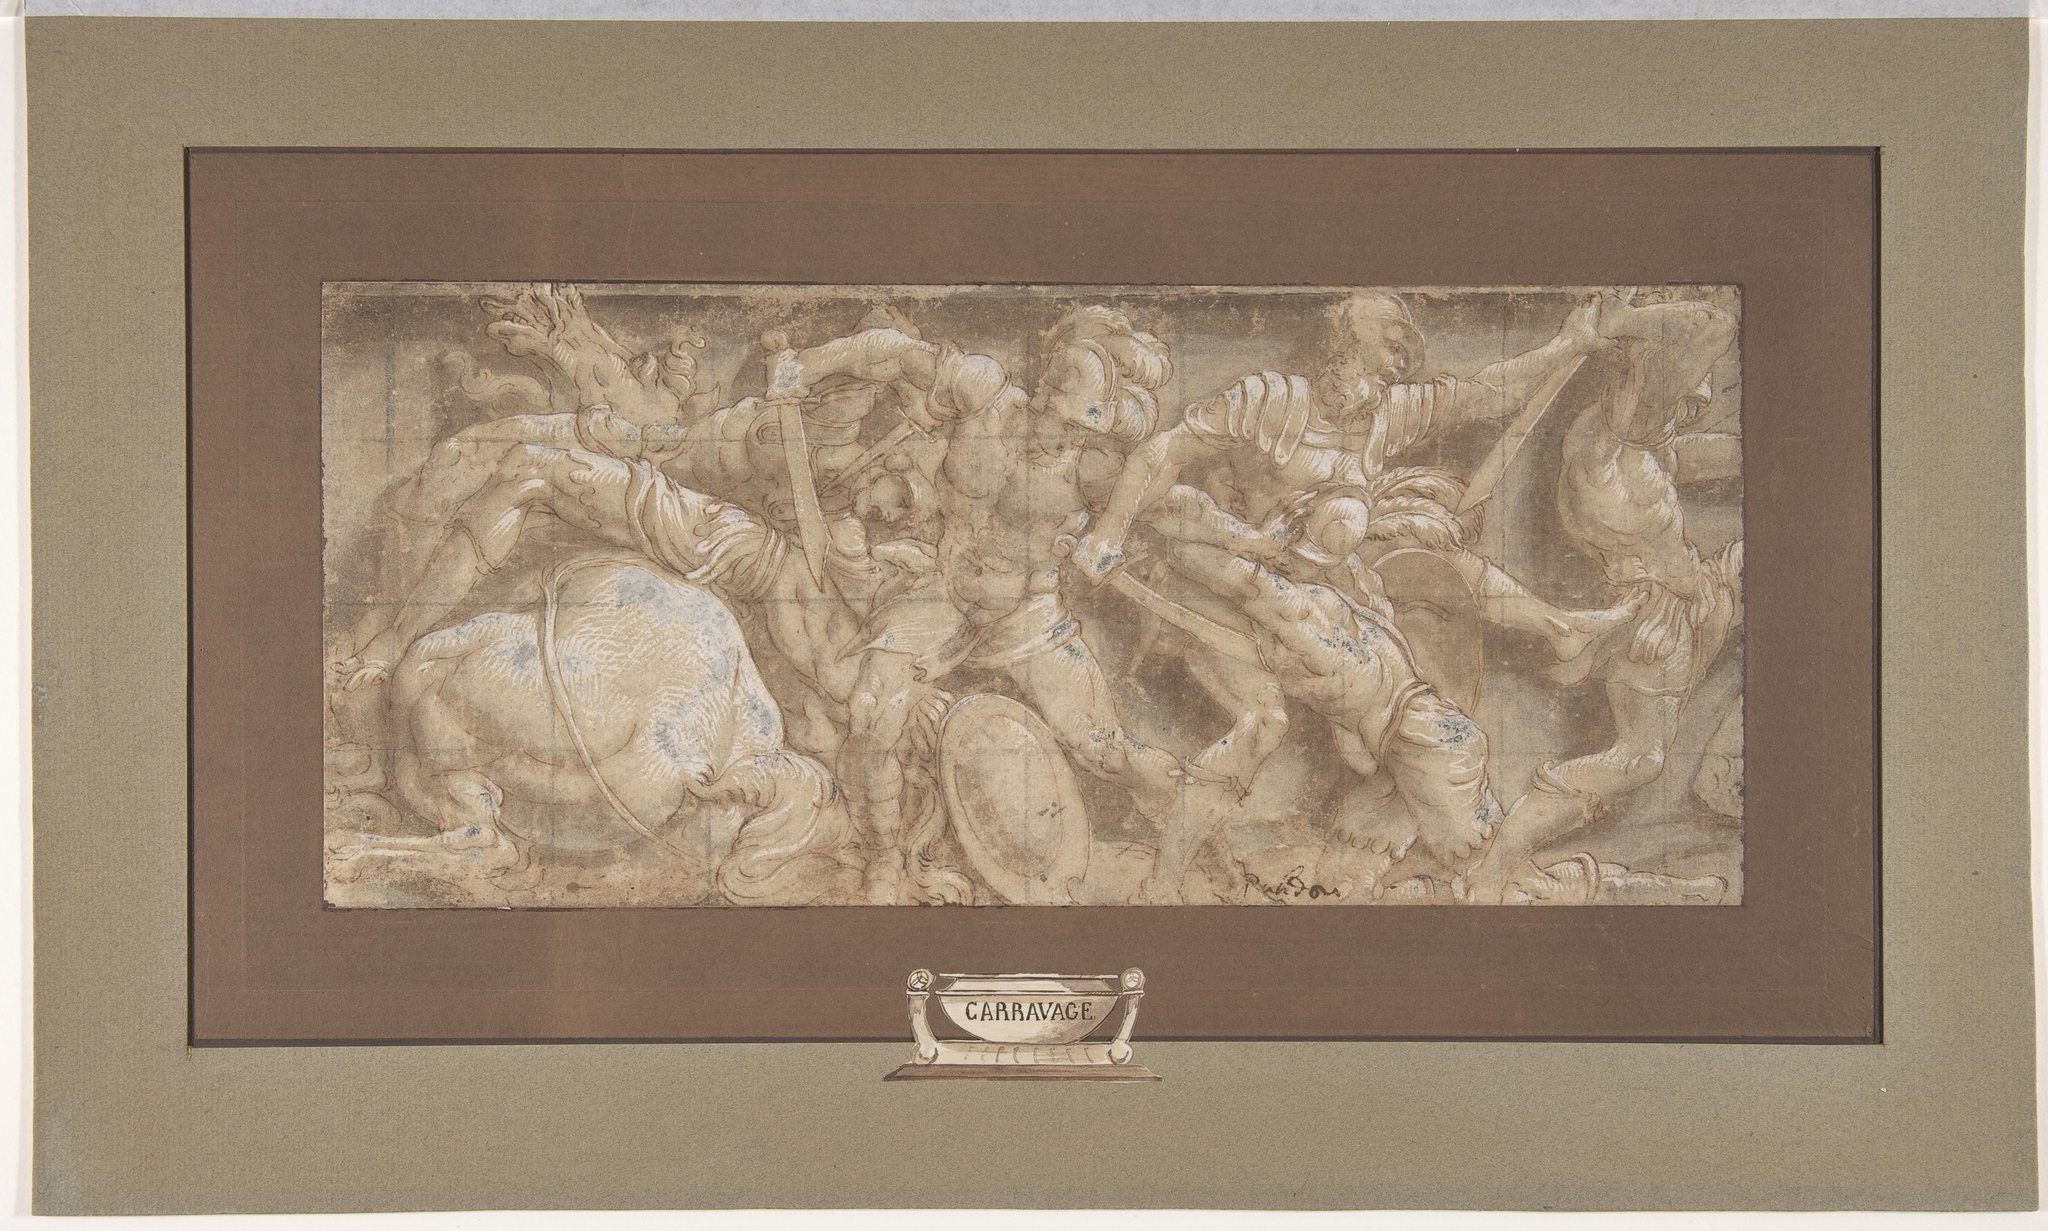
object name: drawing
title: Battle Scene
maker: lelio orsi (called lelio da novellara)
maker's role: artist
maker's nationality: italian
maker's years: 1508-1587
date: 1511-1587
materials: chalk, gouache, ink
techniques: brush, highlighting, pen, drawing, wash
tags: battles,soldiers,shields,swords,horses